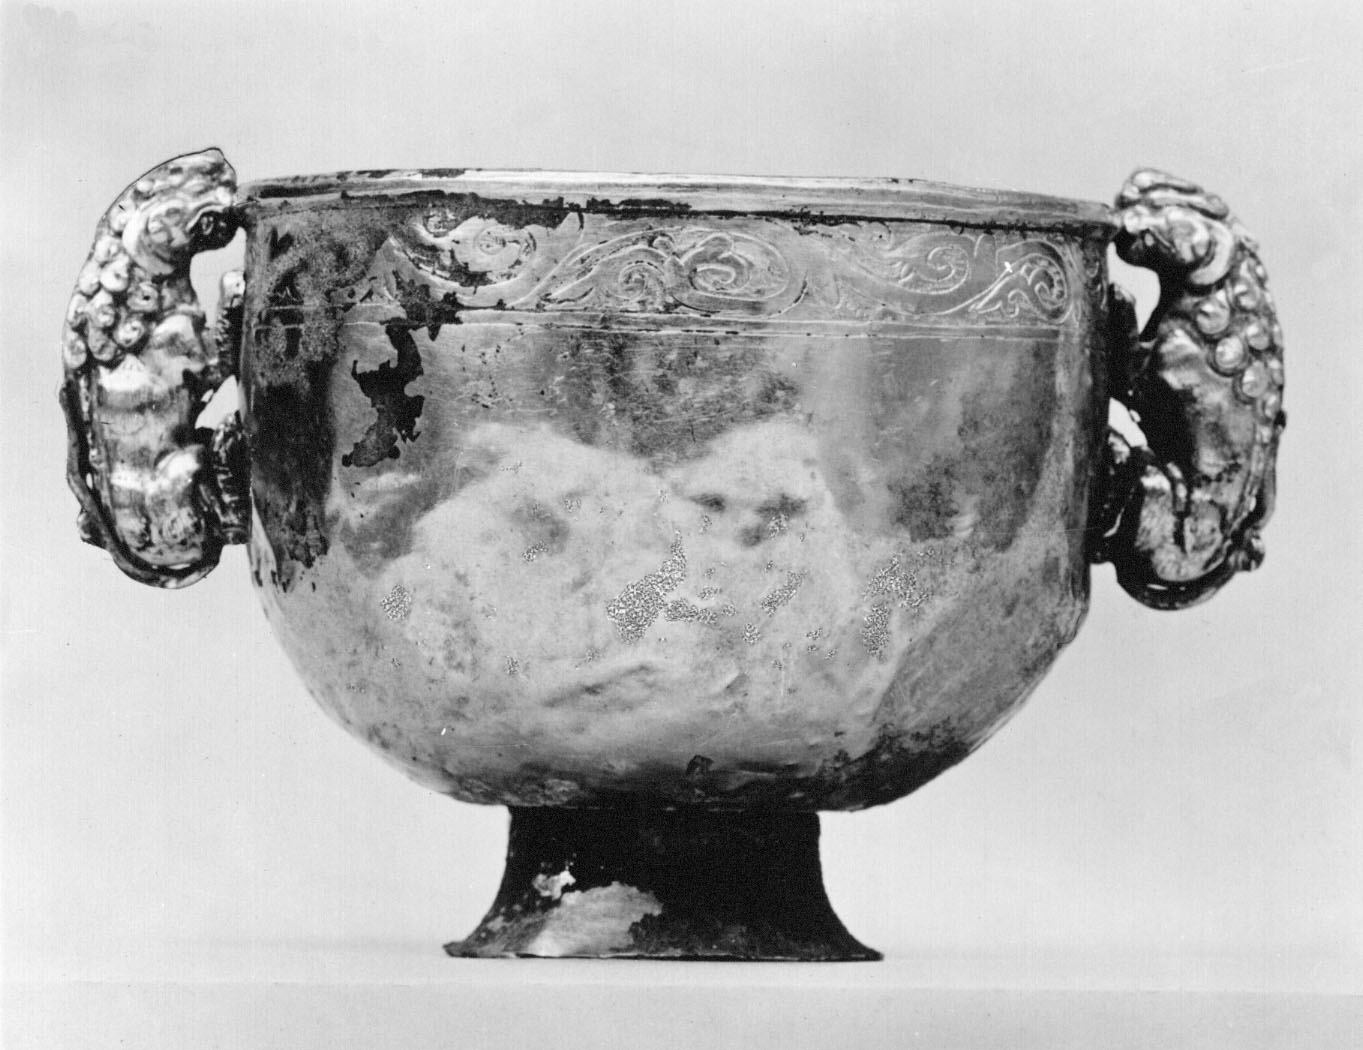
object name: cup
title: Cup with handles in the form of lions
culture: chinese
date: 618-907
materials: gold